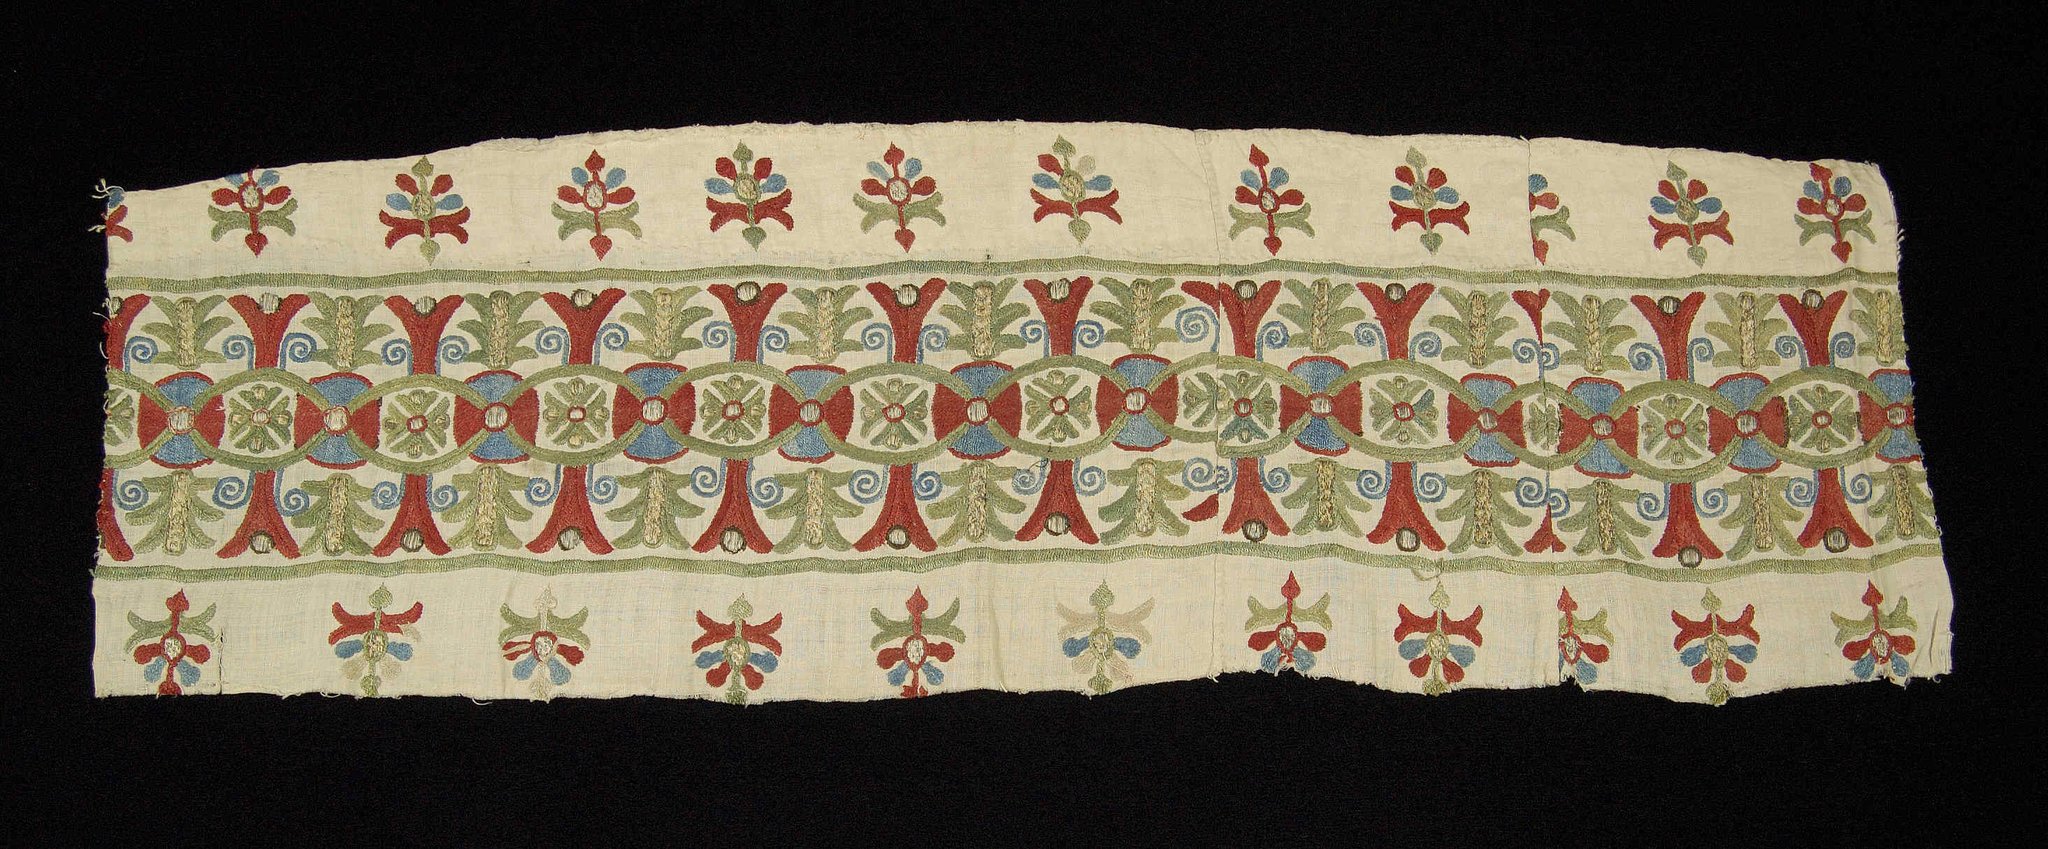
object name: textile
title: Fragment of a shirt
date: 1776-1800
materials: linen, silk